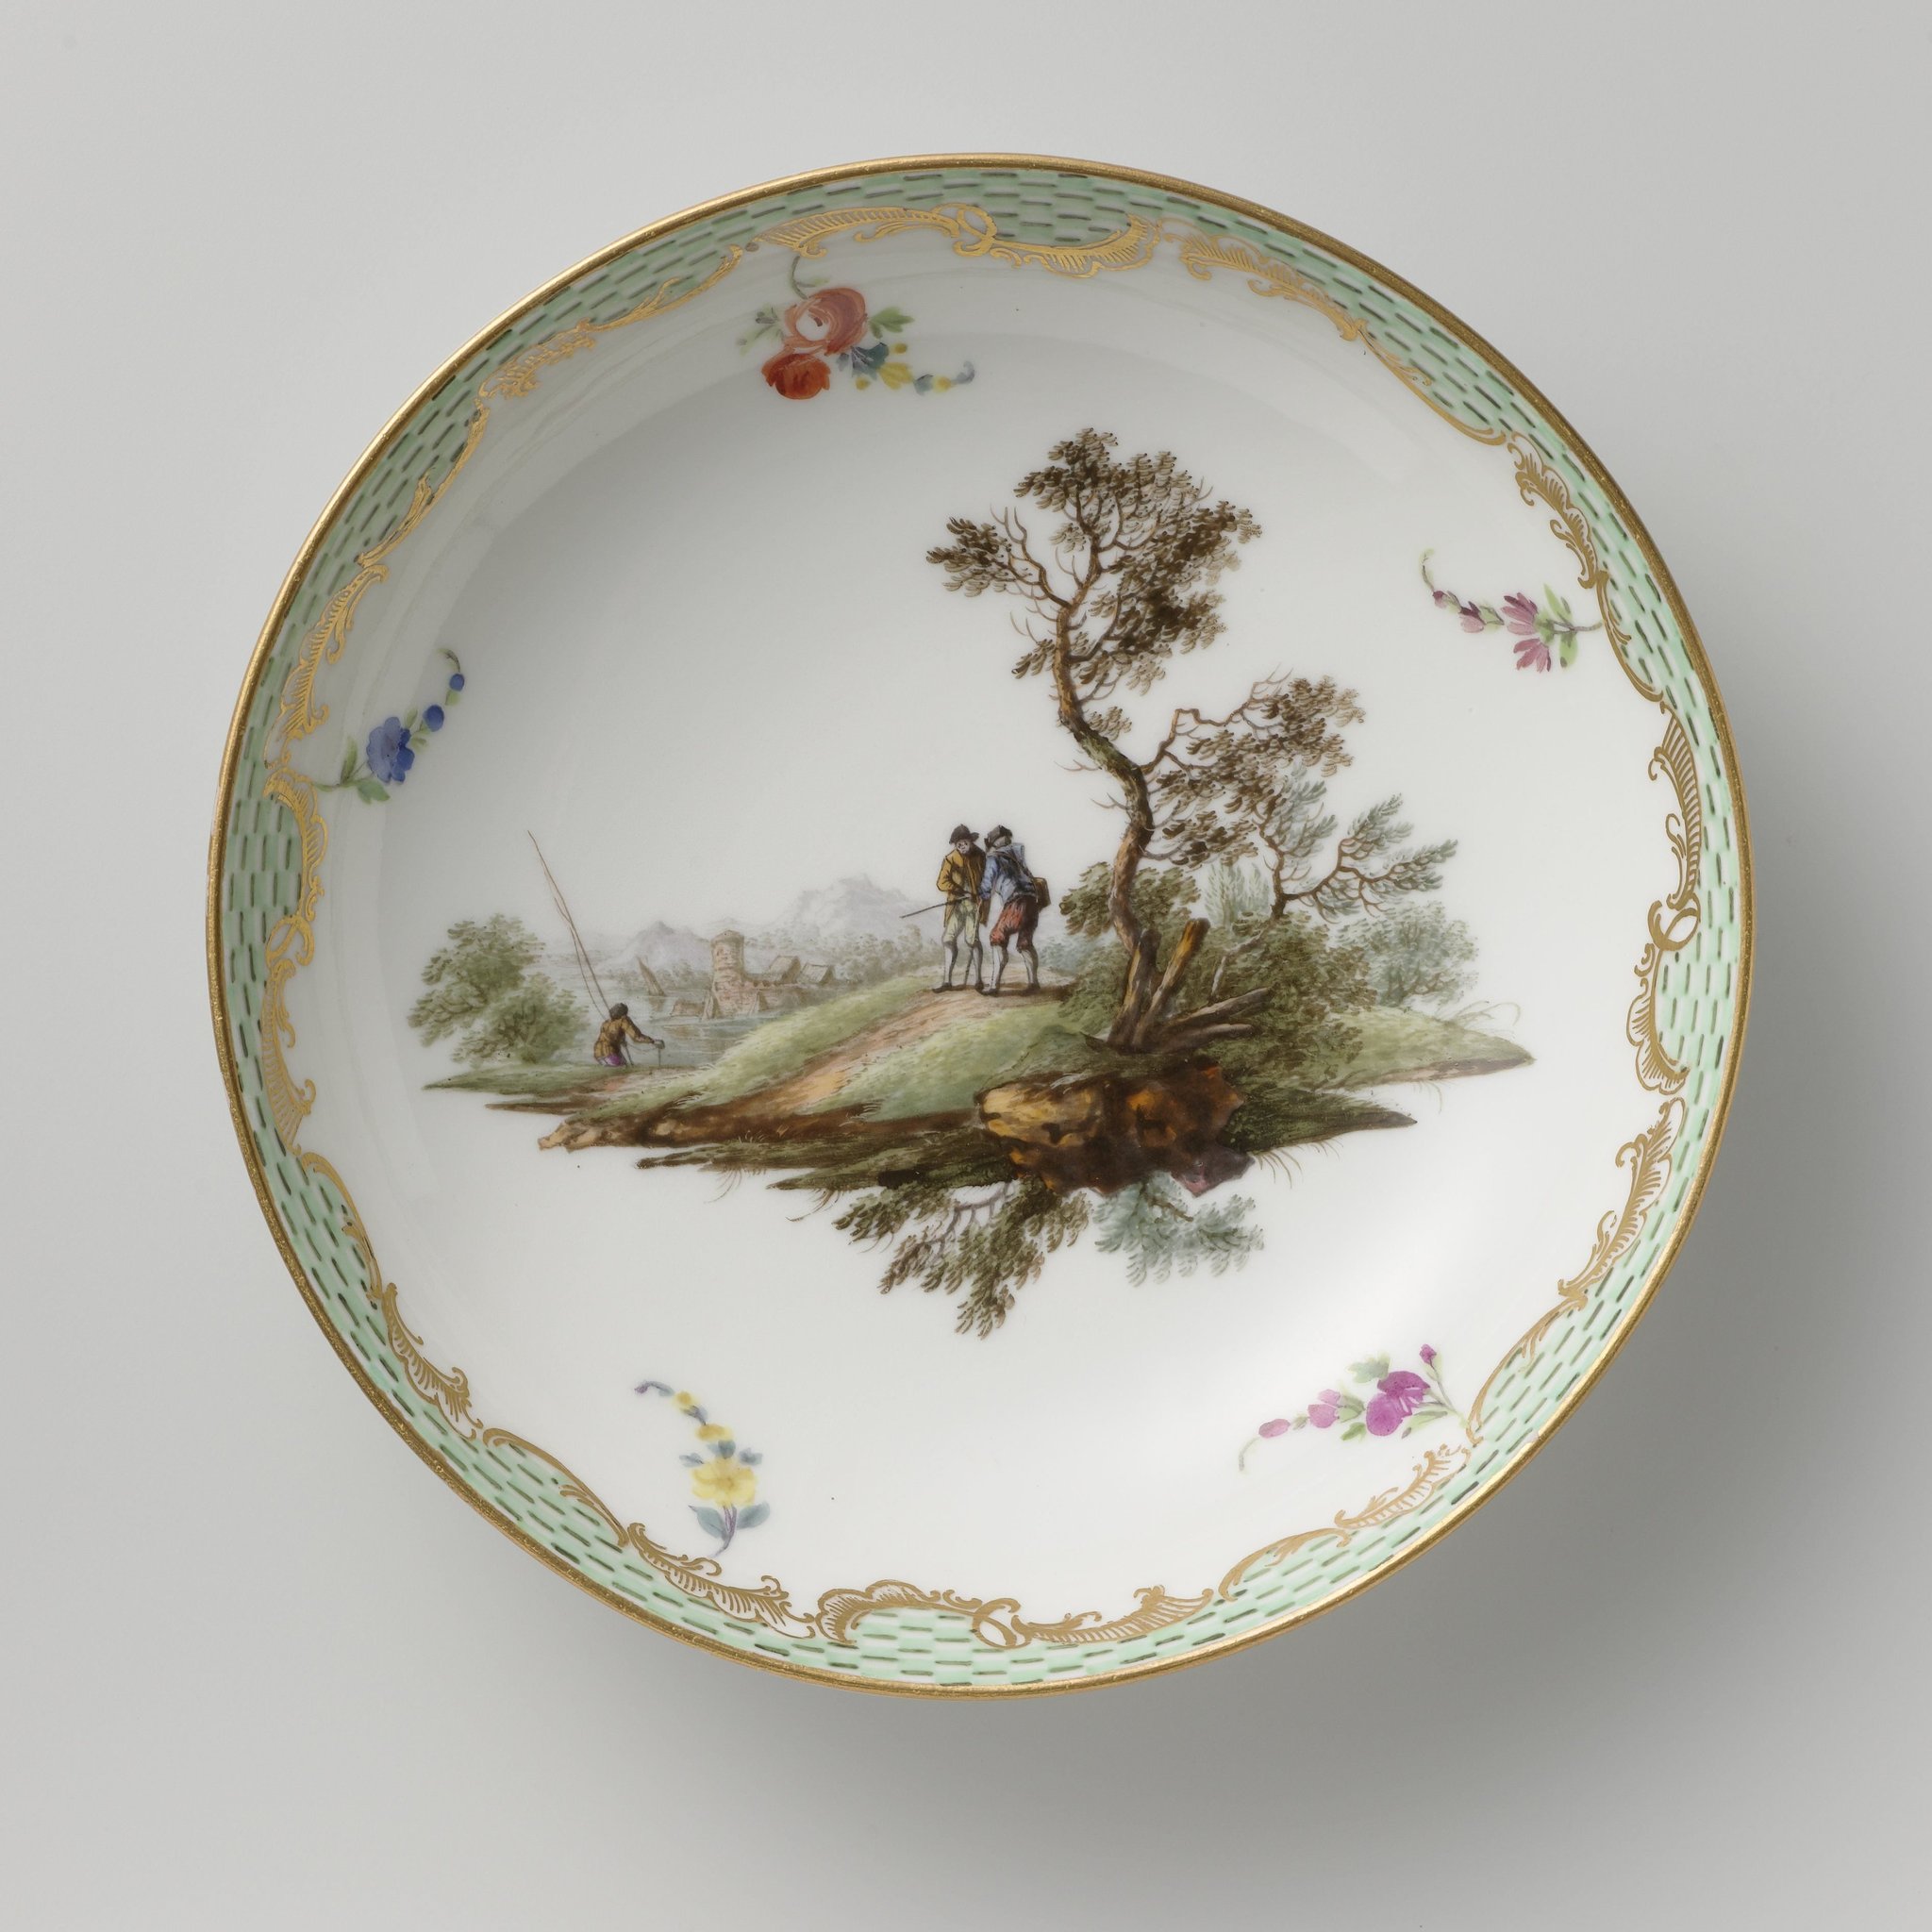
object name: platter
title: Schotel, veelkleurig beschilderd met een landschap met figuren.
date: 1777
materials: porcelain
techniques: painted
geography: meissen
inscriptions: mold mark: ‘5’, factory mark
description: Ronde schotel van beschilderd porselein. De schotel is beschilderd met landschappen waarin figuren en langs de rand een brede strook groen vlechtwerk. De schotel is gemerkt.